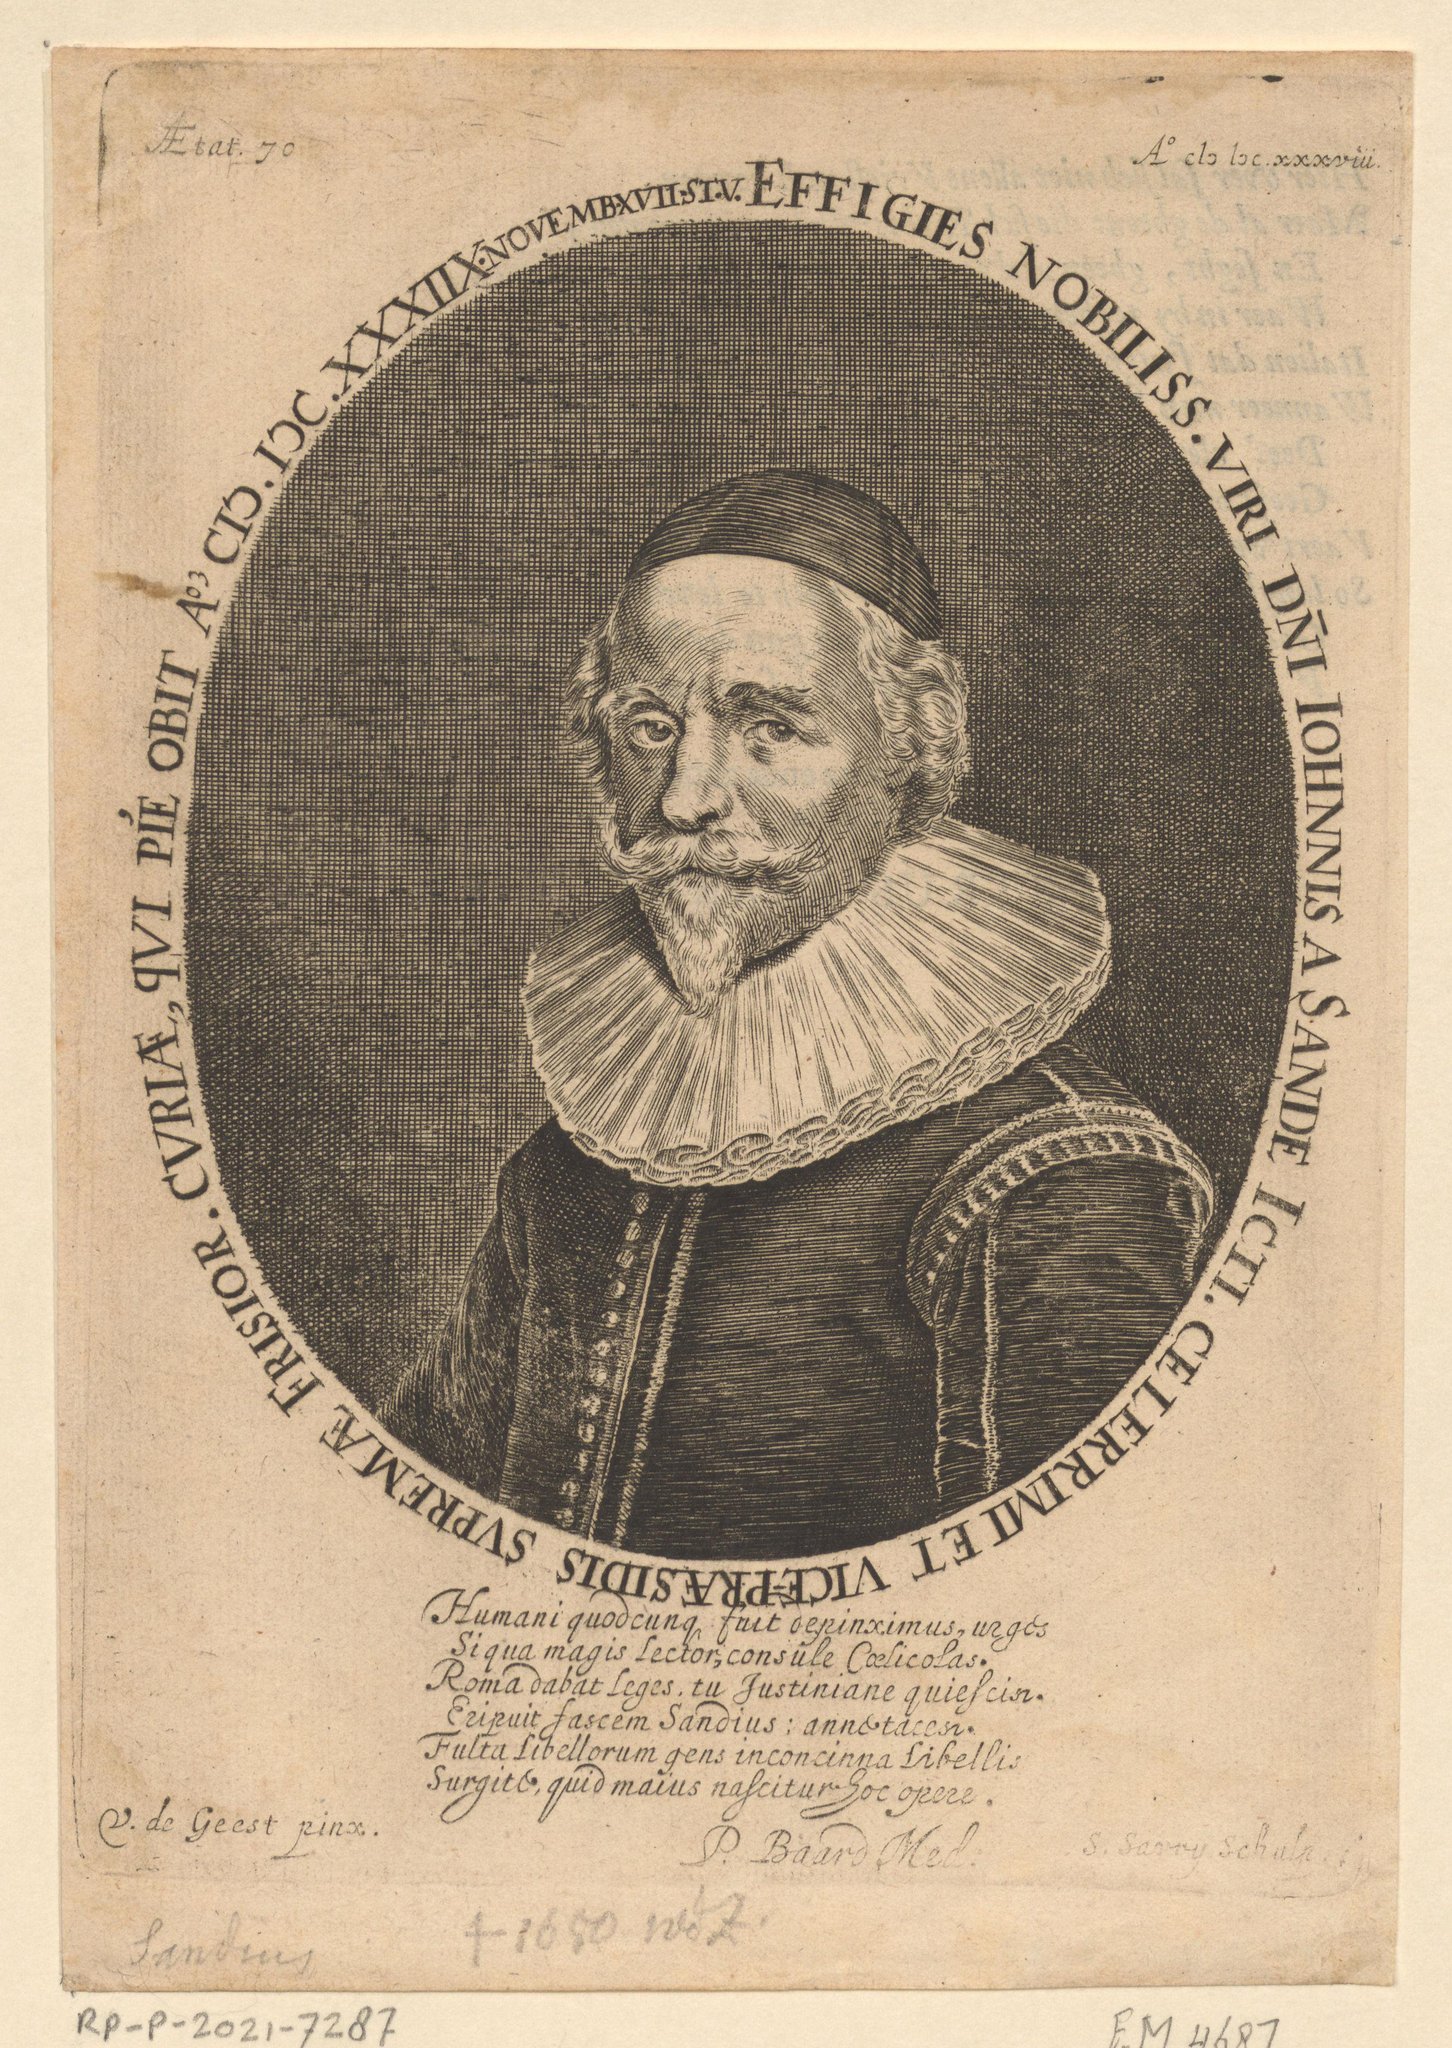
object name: print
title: Portret van Johan van den Sande op 70-jarige leeftijd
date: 1652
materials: paper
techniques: engraving, letterpress printing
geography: leeuwarden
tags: arnhem, johan van den sande, historical persons, portrait of a writer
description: Prent uit: Sande, Johan van der. Vijf boecken der gewysder saecken voor den hove van Vries-land (...). Leeuwarden: s.n., 1652.